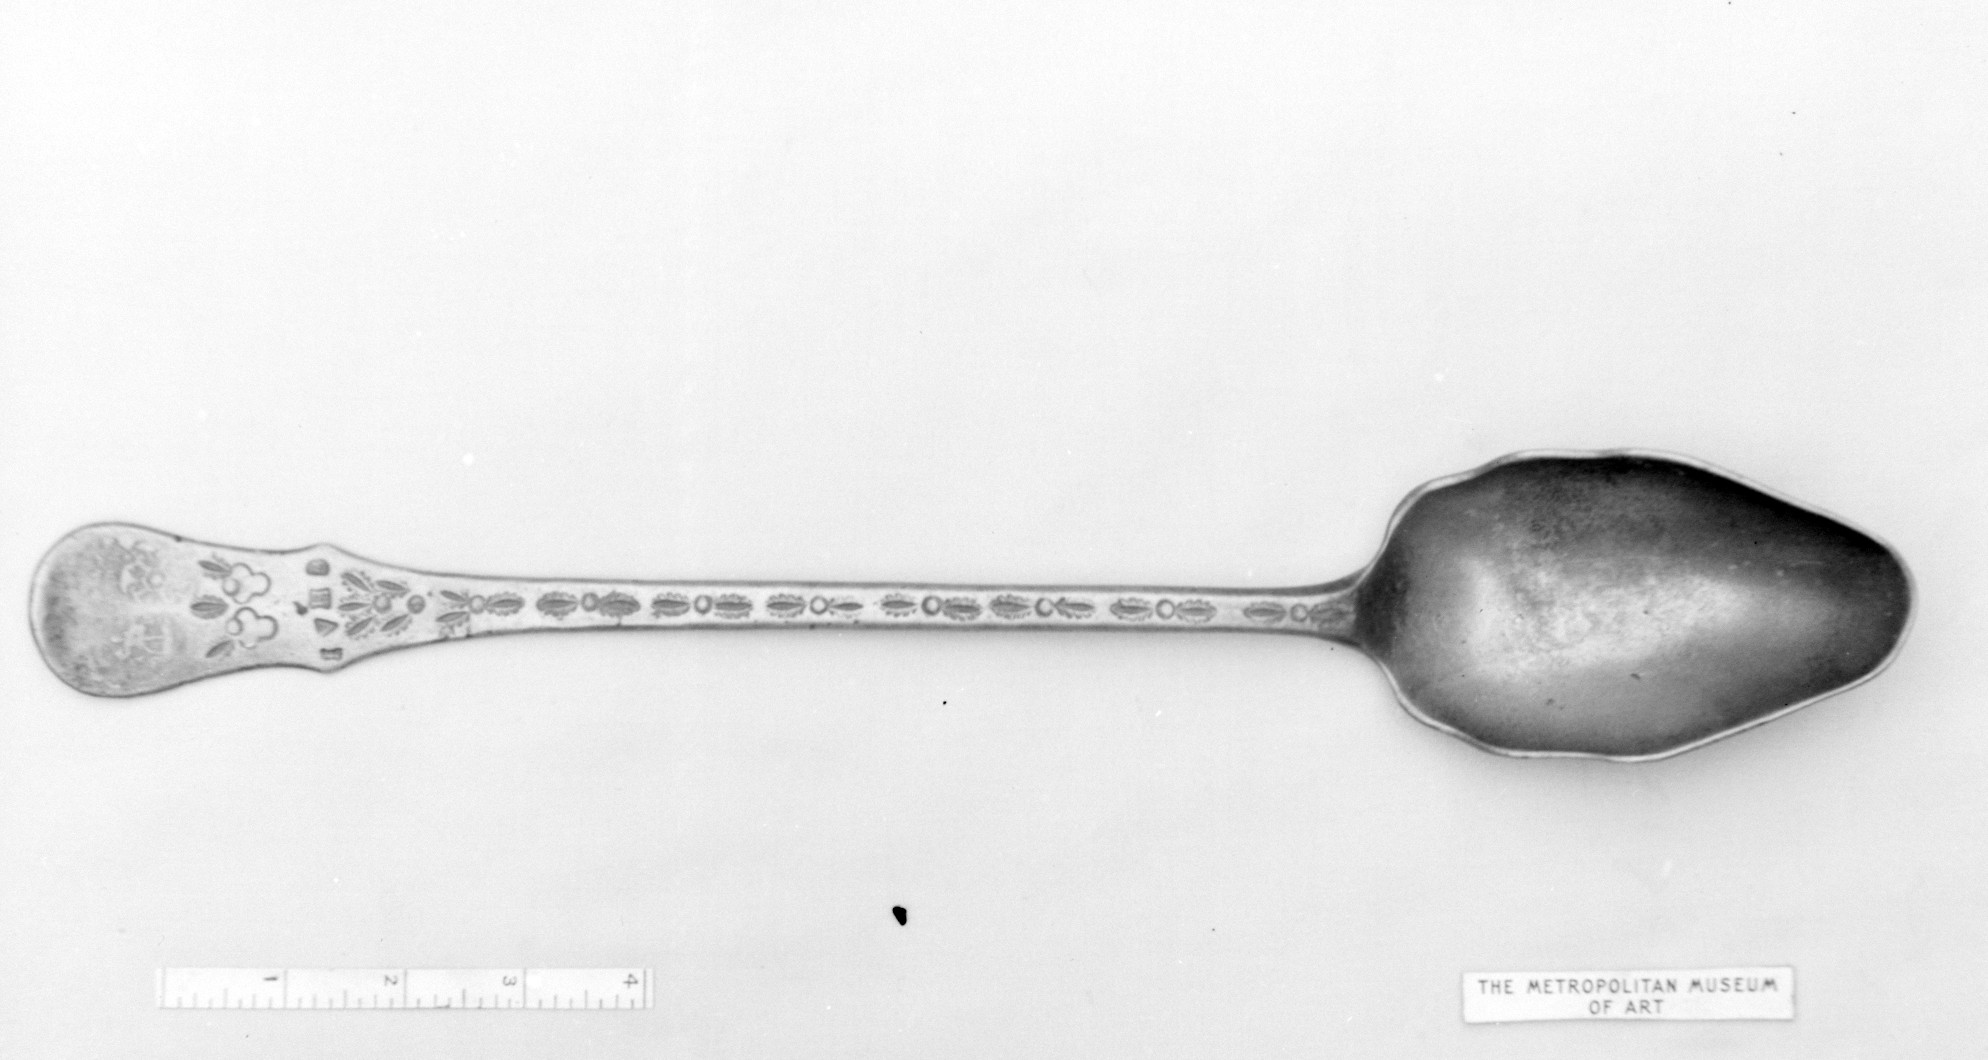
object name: spoon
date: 1767-1800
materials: pewter